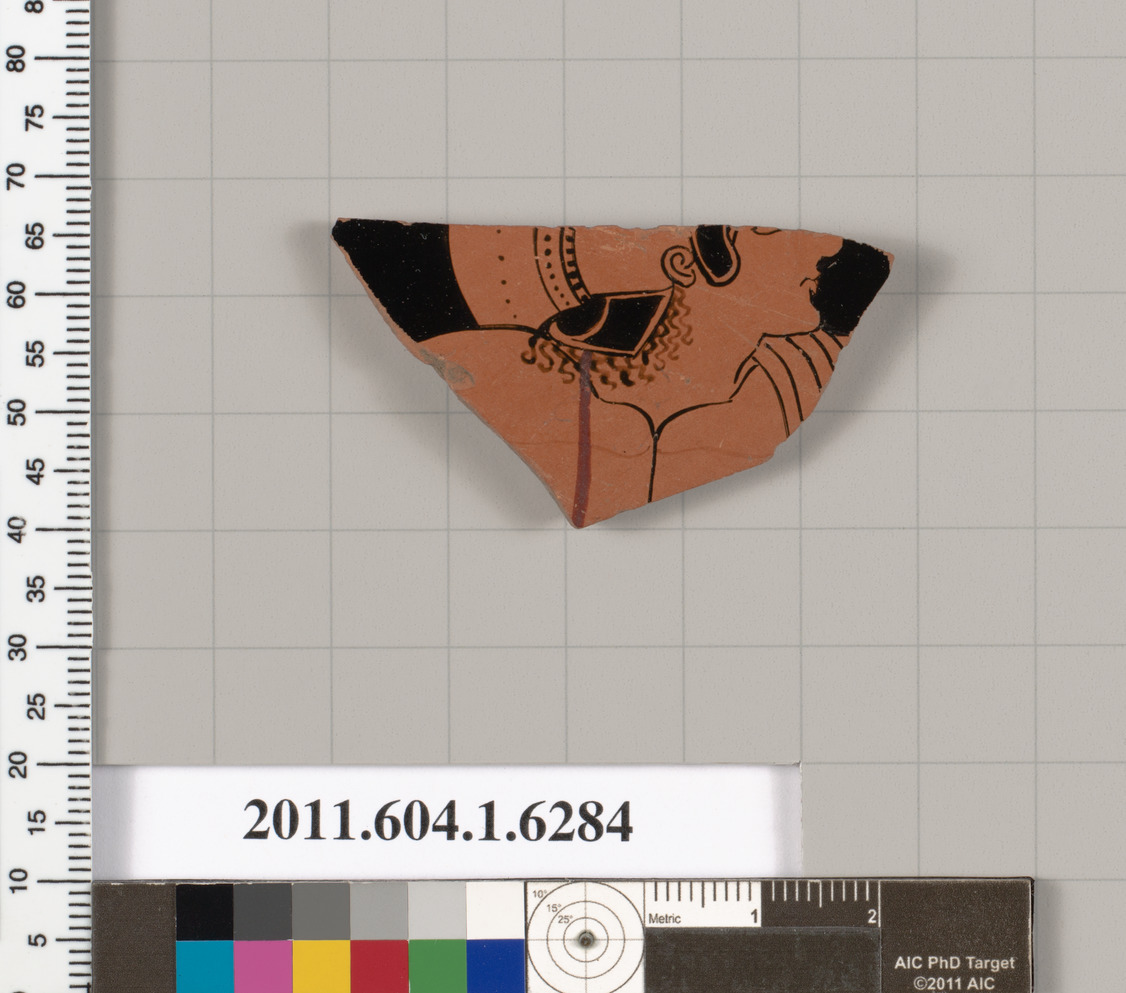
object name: kylix fragment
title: Terracotta fragment of a kylix (drinking cup)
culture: greek, attic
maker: onesimos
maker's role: artist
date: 500-480 BCE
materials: terracotta